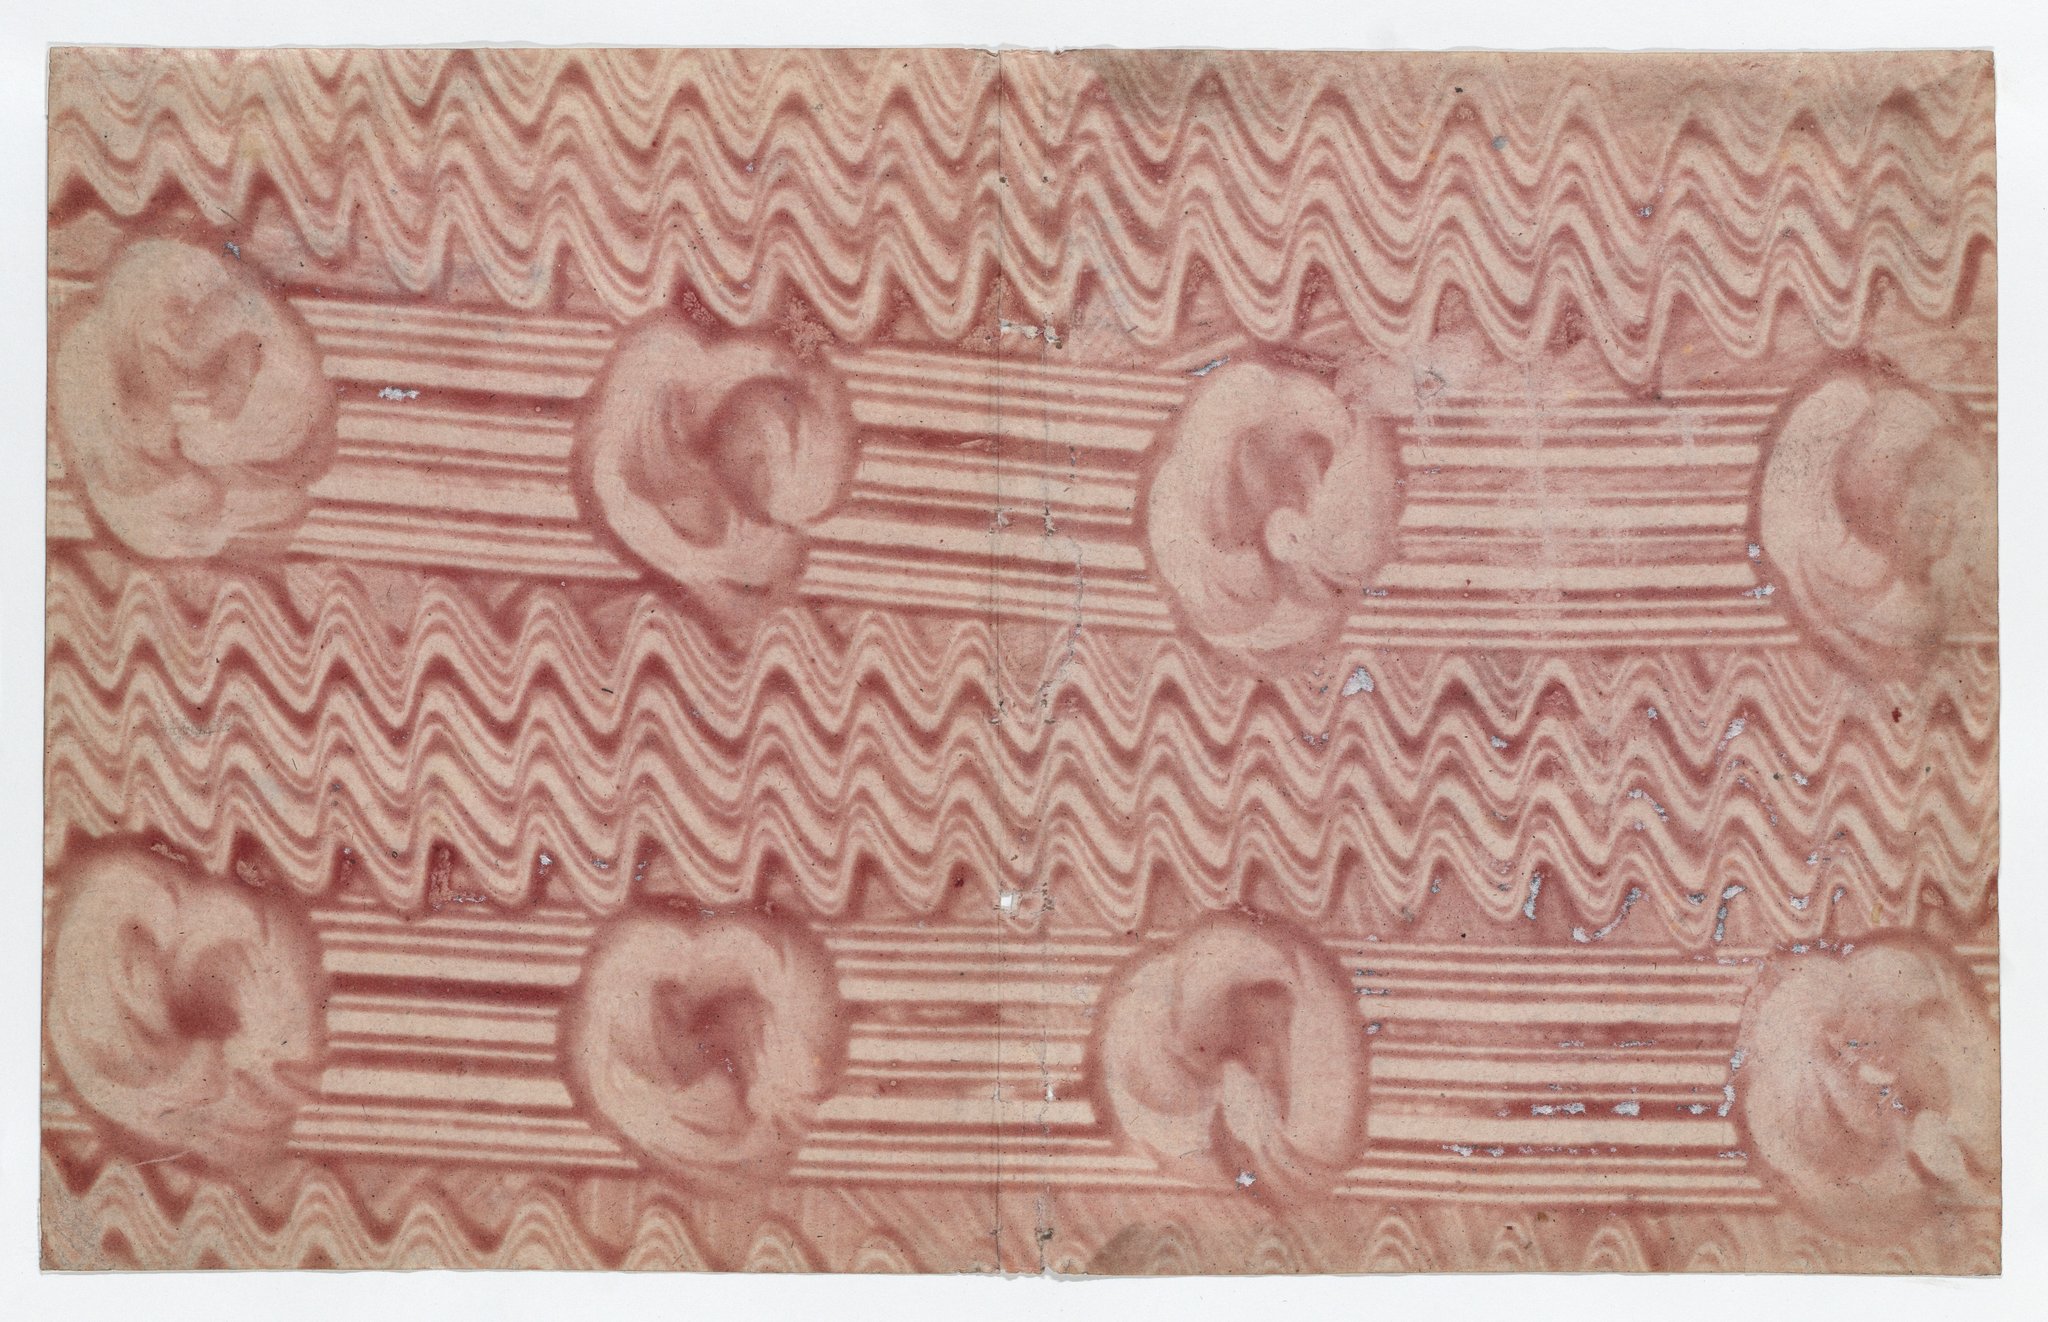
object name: print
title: Book cover with overall red curved line pattern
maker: Anonymous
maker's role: artist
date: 1801-1900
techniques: relief print